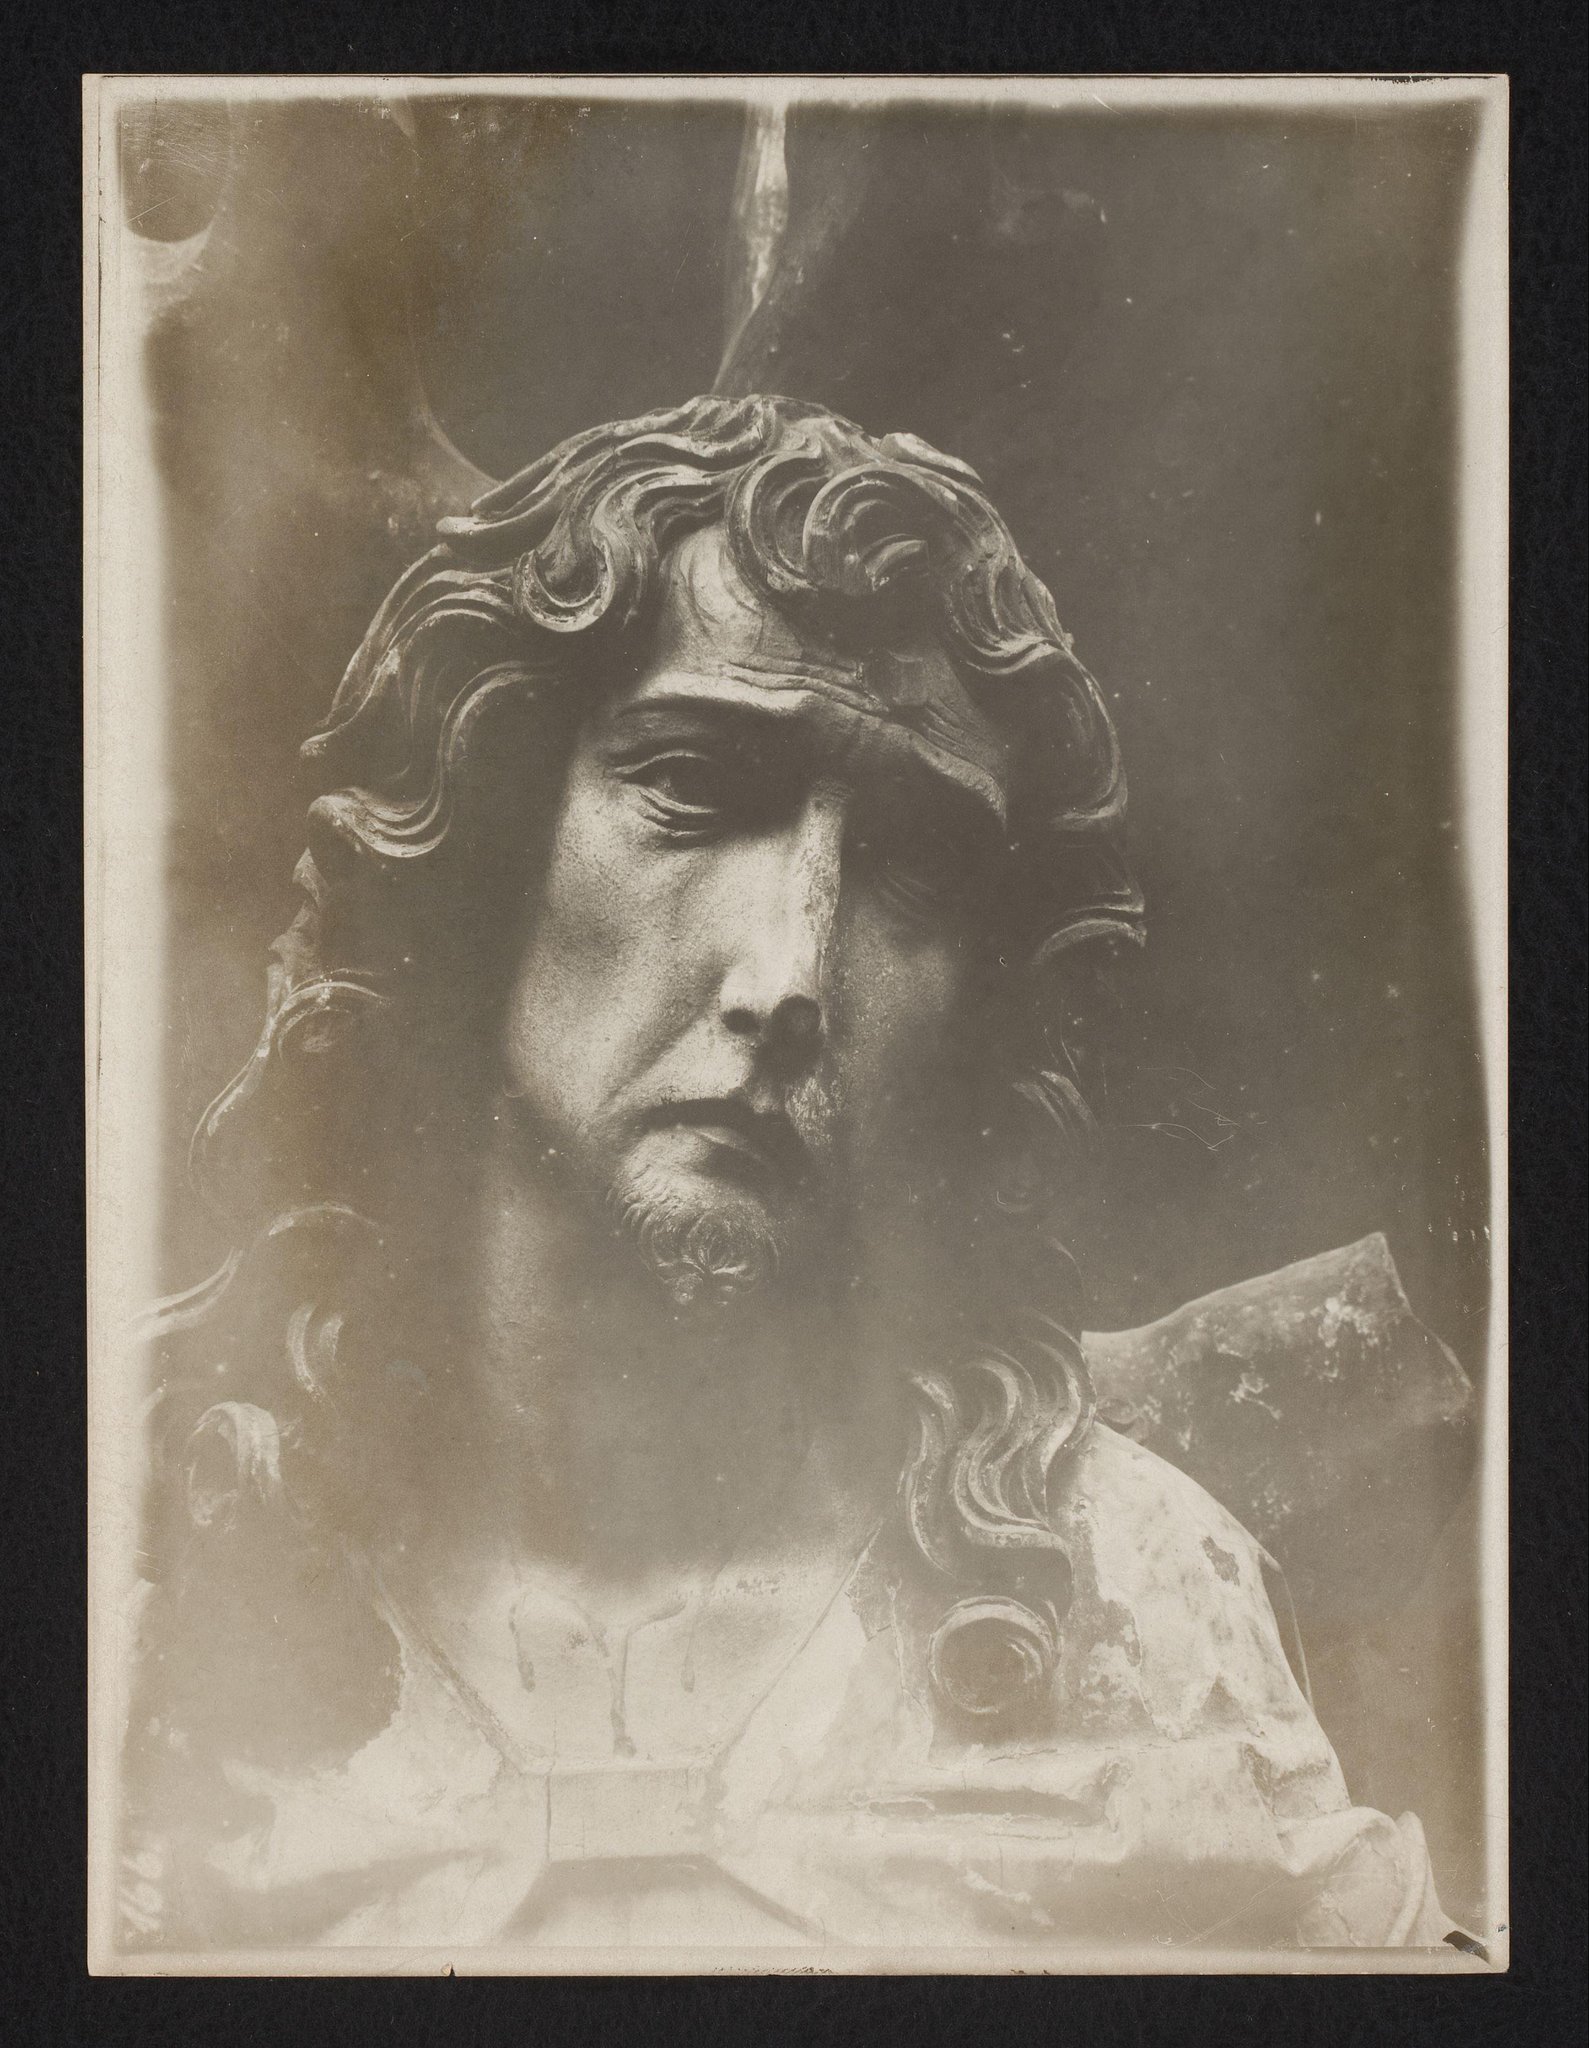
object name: album leaf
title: Detail van het Riemenschneideraltar in de dom van Bamberg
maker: Anonymous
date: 1900-1920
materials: paper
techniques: gelatin silver print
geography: bamberg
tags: interior of church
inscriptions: inscription: ‘Kunsthist. Seminar/ Marburg (Lahn)/ Photogr. Abteilung/ Vervielfältigung/ untersagt.’, inscription: ‘Bamberg/ 166’